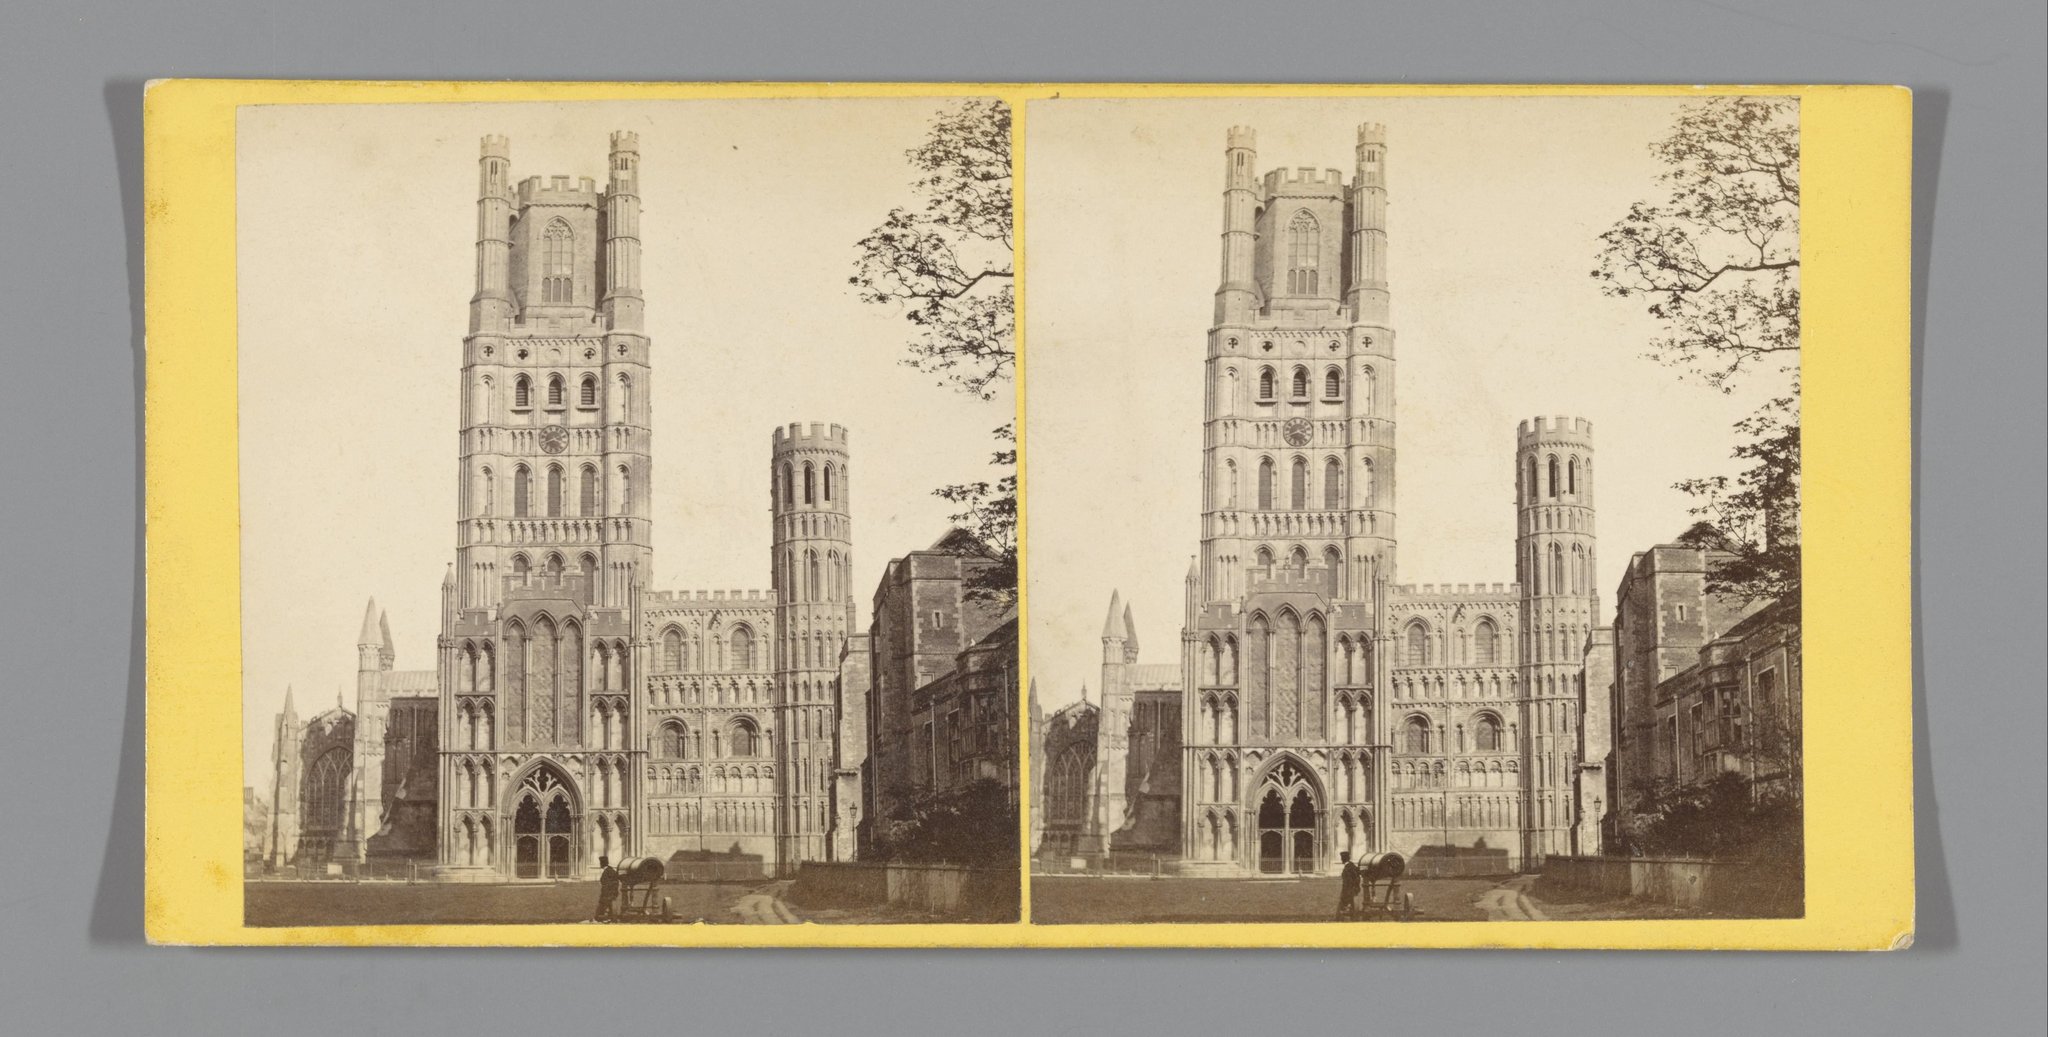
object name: stereograph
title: Ely Cathedral: View of the West Front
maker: alexander wilson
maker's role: fotograaf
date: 1850-1880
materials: cardboard, photographic support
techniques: albumen print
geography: ely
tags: church (exterior), façade (of house or building), parts of church exterior and annexes: tower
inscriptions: number: ‘No. 133.’, name: ‘Alexander Wilson, Photographer, Leamington.’